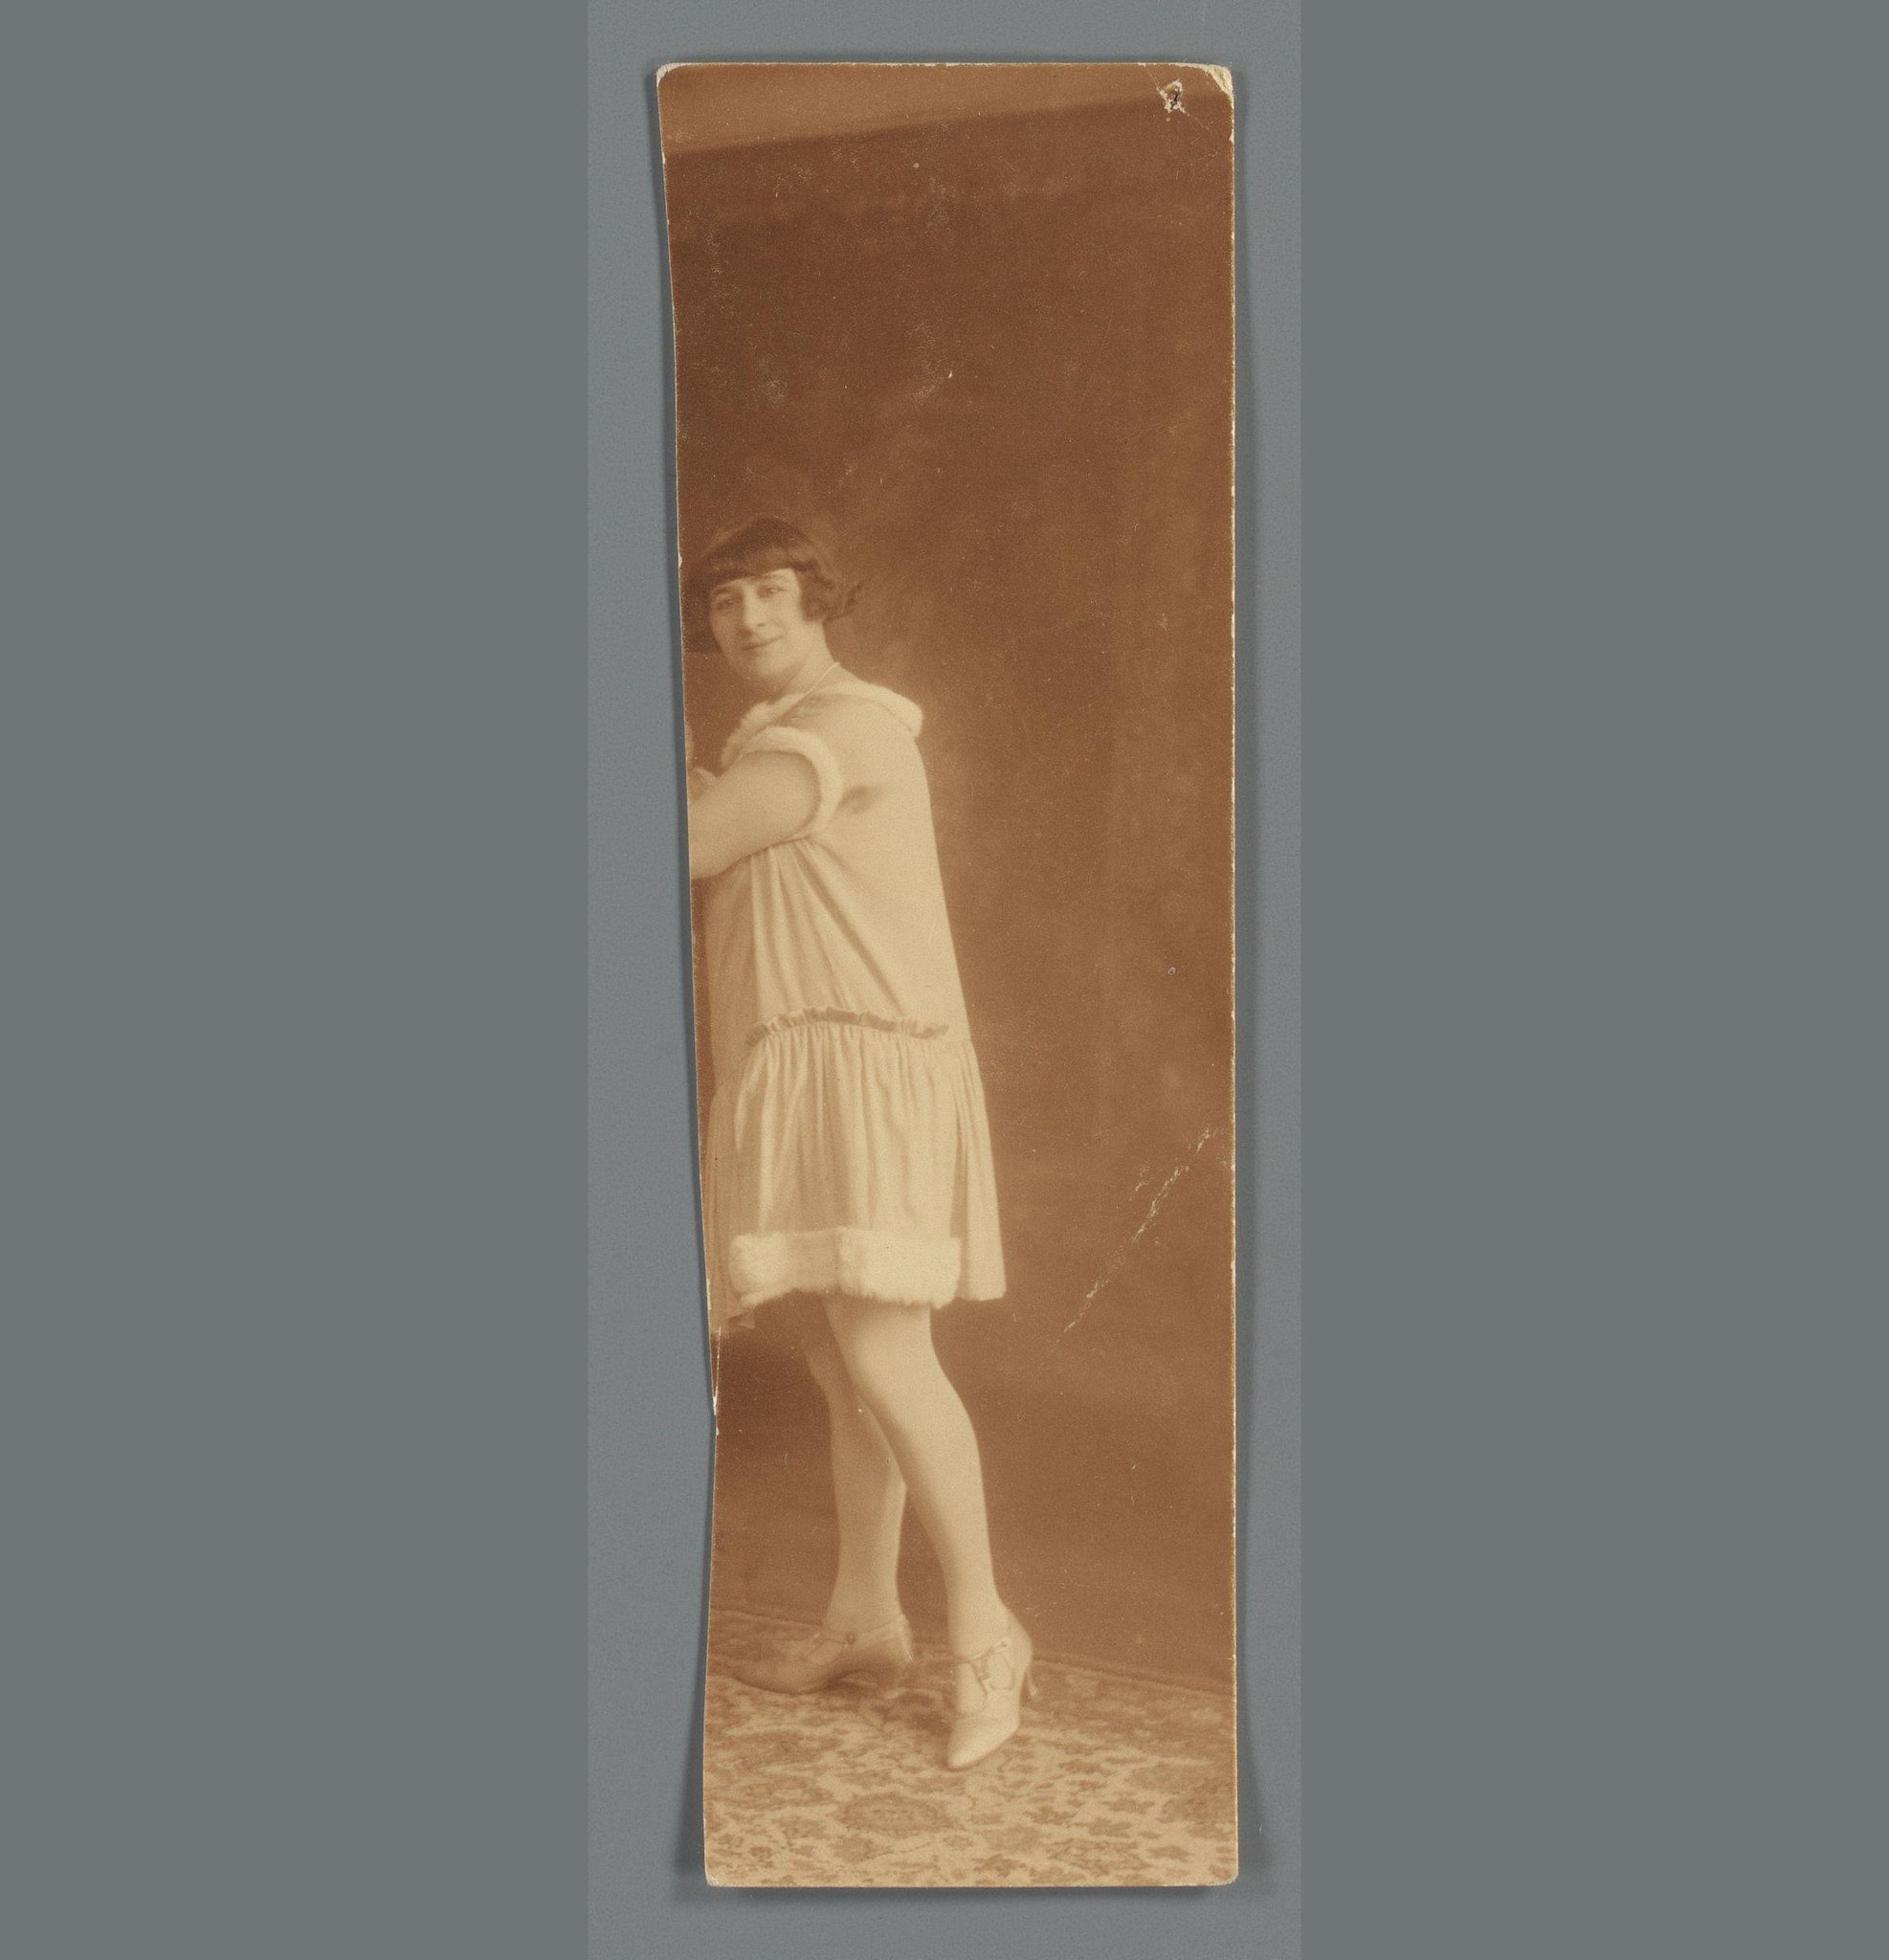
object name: photograph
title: Portret van Cato Merks in een fotostudio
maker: wilhelm coenraad dettmeijer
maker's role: fotograaf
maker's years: 1892-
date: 1927-1934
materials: paper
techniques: gelatin silver print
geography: rotterdam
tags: historical persons - bb - woman, portrait of cabaret-artiste, rotterdam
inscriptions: inscription: ‘Dettmeijer/ Goudsch/ Rot’, inscription: ‘Cato Merks./ Kruiskade 108/ R'dam’